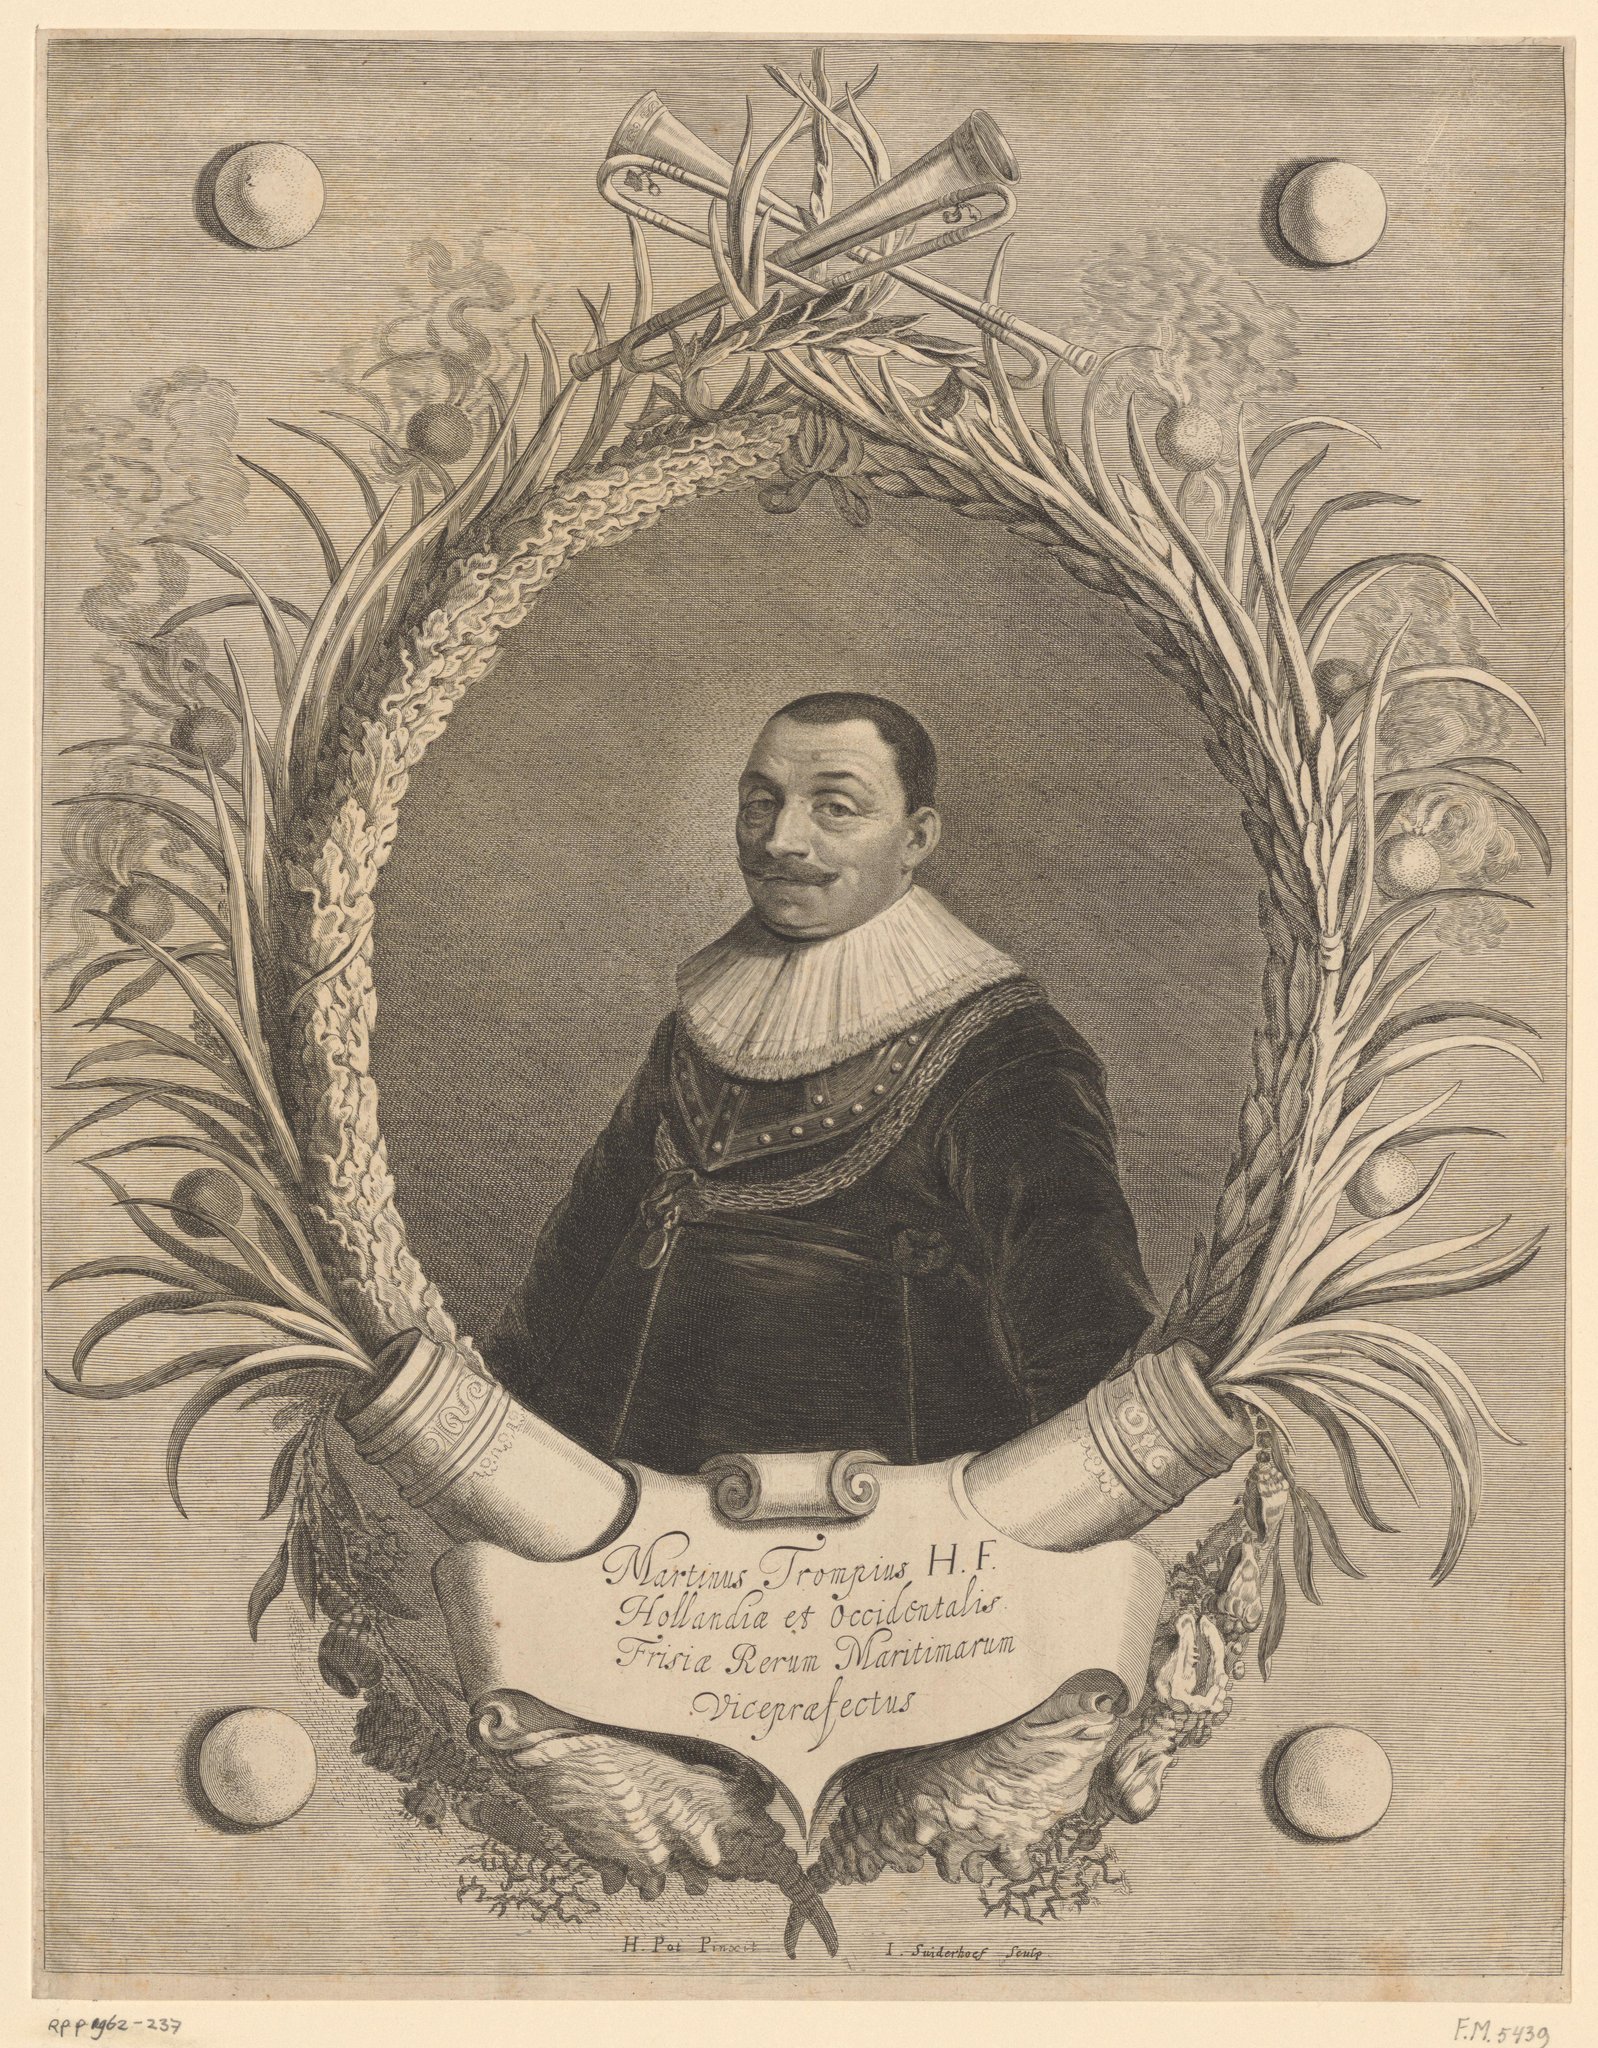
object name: print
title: Portret van Maarten Harpertszoon Tromp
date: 1623-1686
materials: paper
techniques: engraving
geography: haarlem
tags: brielle, maarten harpertszoon tromp, historical persons, firearms: cannon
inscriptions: inscription: ‘leith/ march 20/ 1843’, collector's mark: Lugt 151, mark: ‘hx’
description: Portret van Maarten Harpertszoon Tromp, luitenant-admiraal van Holland en West-Friesland, in een decoratieve omlijsting van lauwertakken, kanonnen en kanonskogels. De lijst wordt bekroond door twee trompetten.